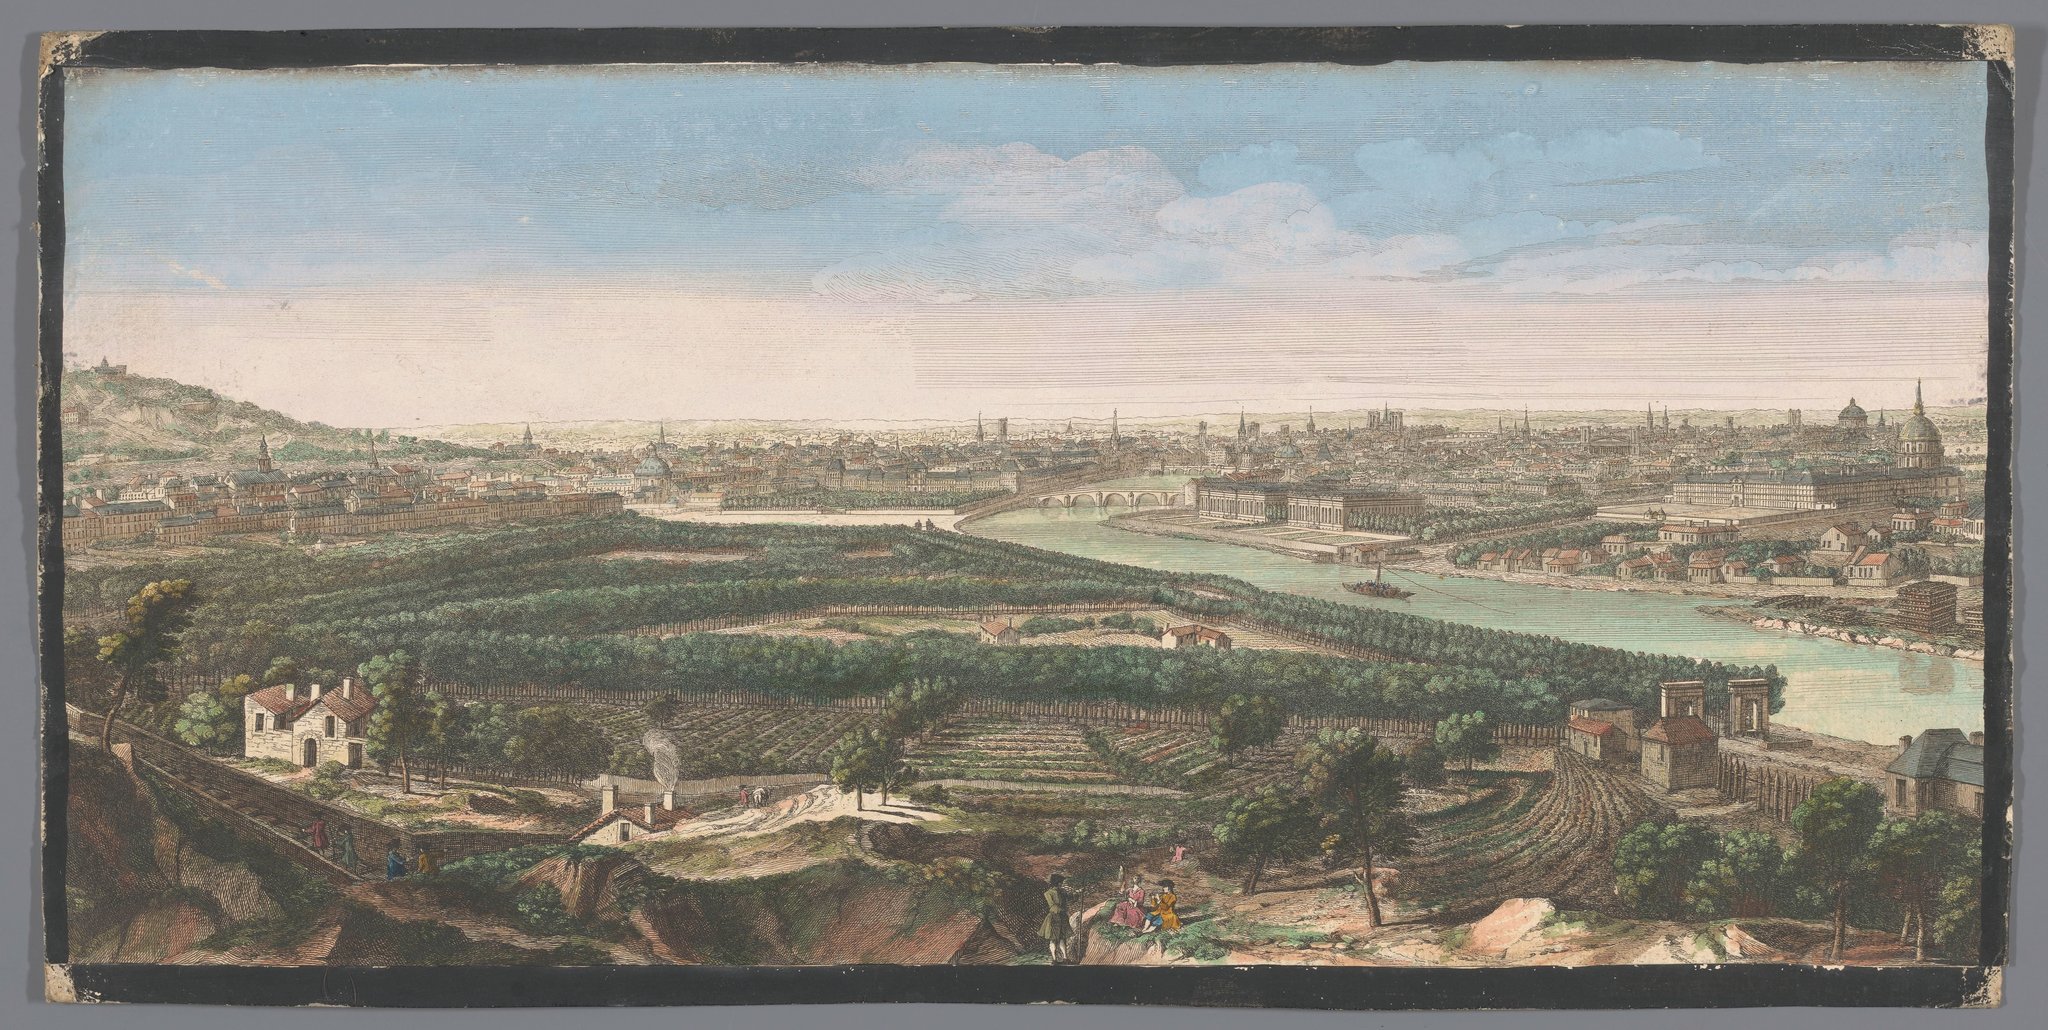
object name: print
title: Vuë générale de la ville de Paris, prise de la hauteur du village de Chaillot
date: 1700-1799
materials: cardboard, paper, watercolor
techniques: brush, etching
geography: paris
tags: city-view in general; 'veduta', paris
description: In de ondermarge een regel Franse tekst.